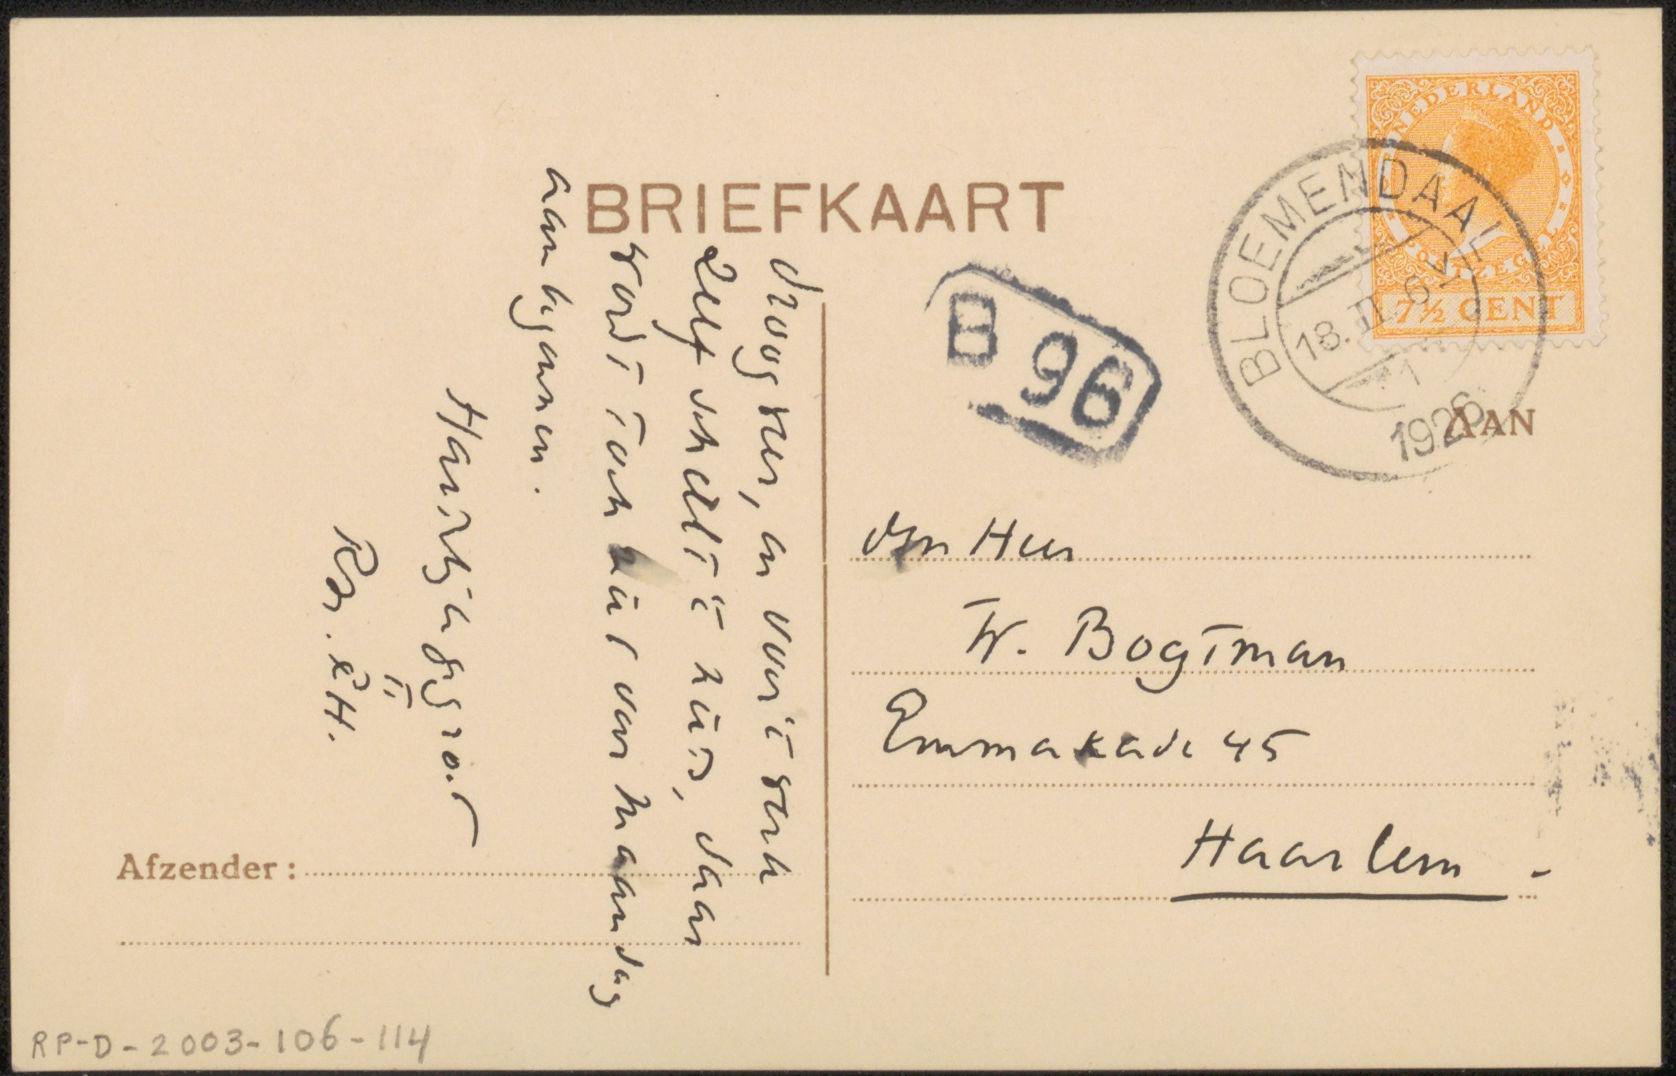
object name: postcard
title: Briefkaart aan Willem Bogtman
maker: richard nicolaüs roland holst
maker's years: 1868-1938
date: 1926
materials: cardboard, ink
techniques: pen, writing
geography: bloemendaal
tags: willem bogtman, drawing, applied arts, arts and crafts; industrial design